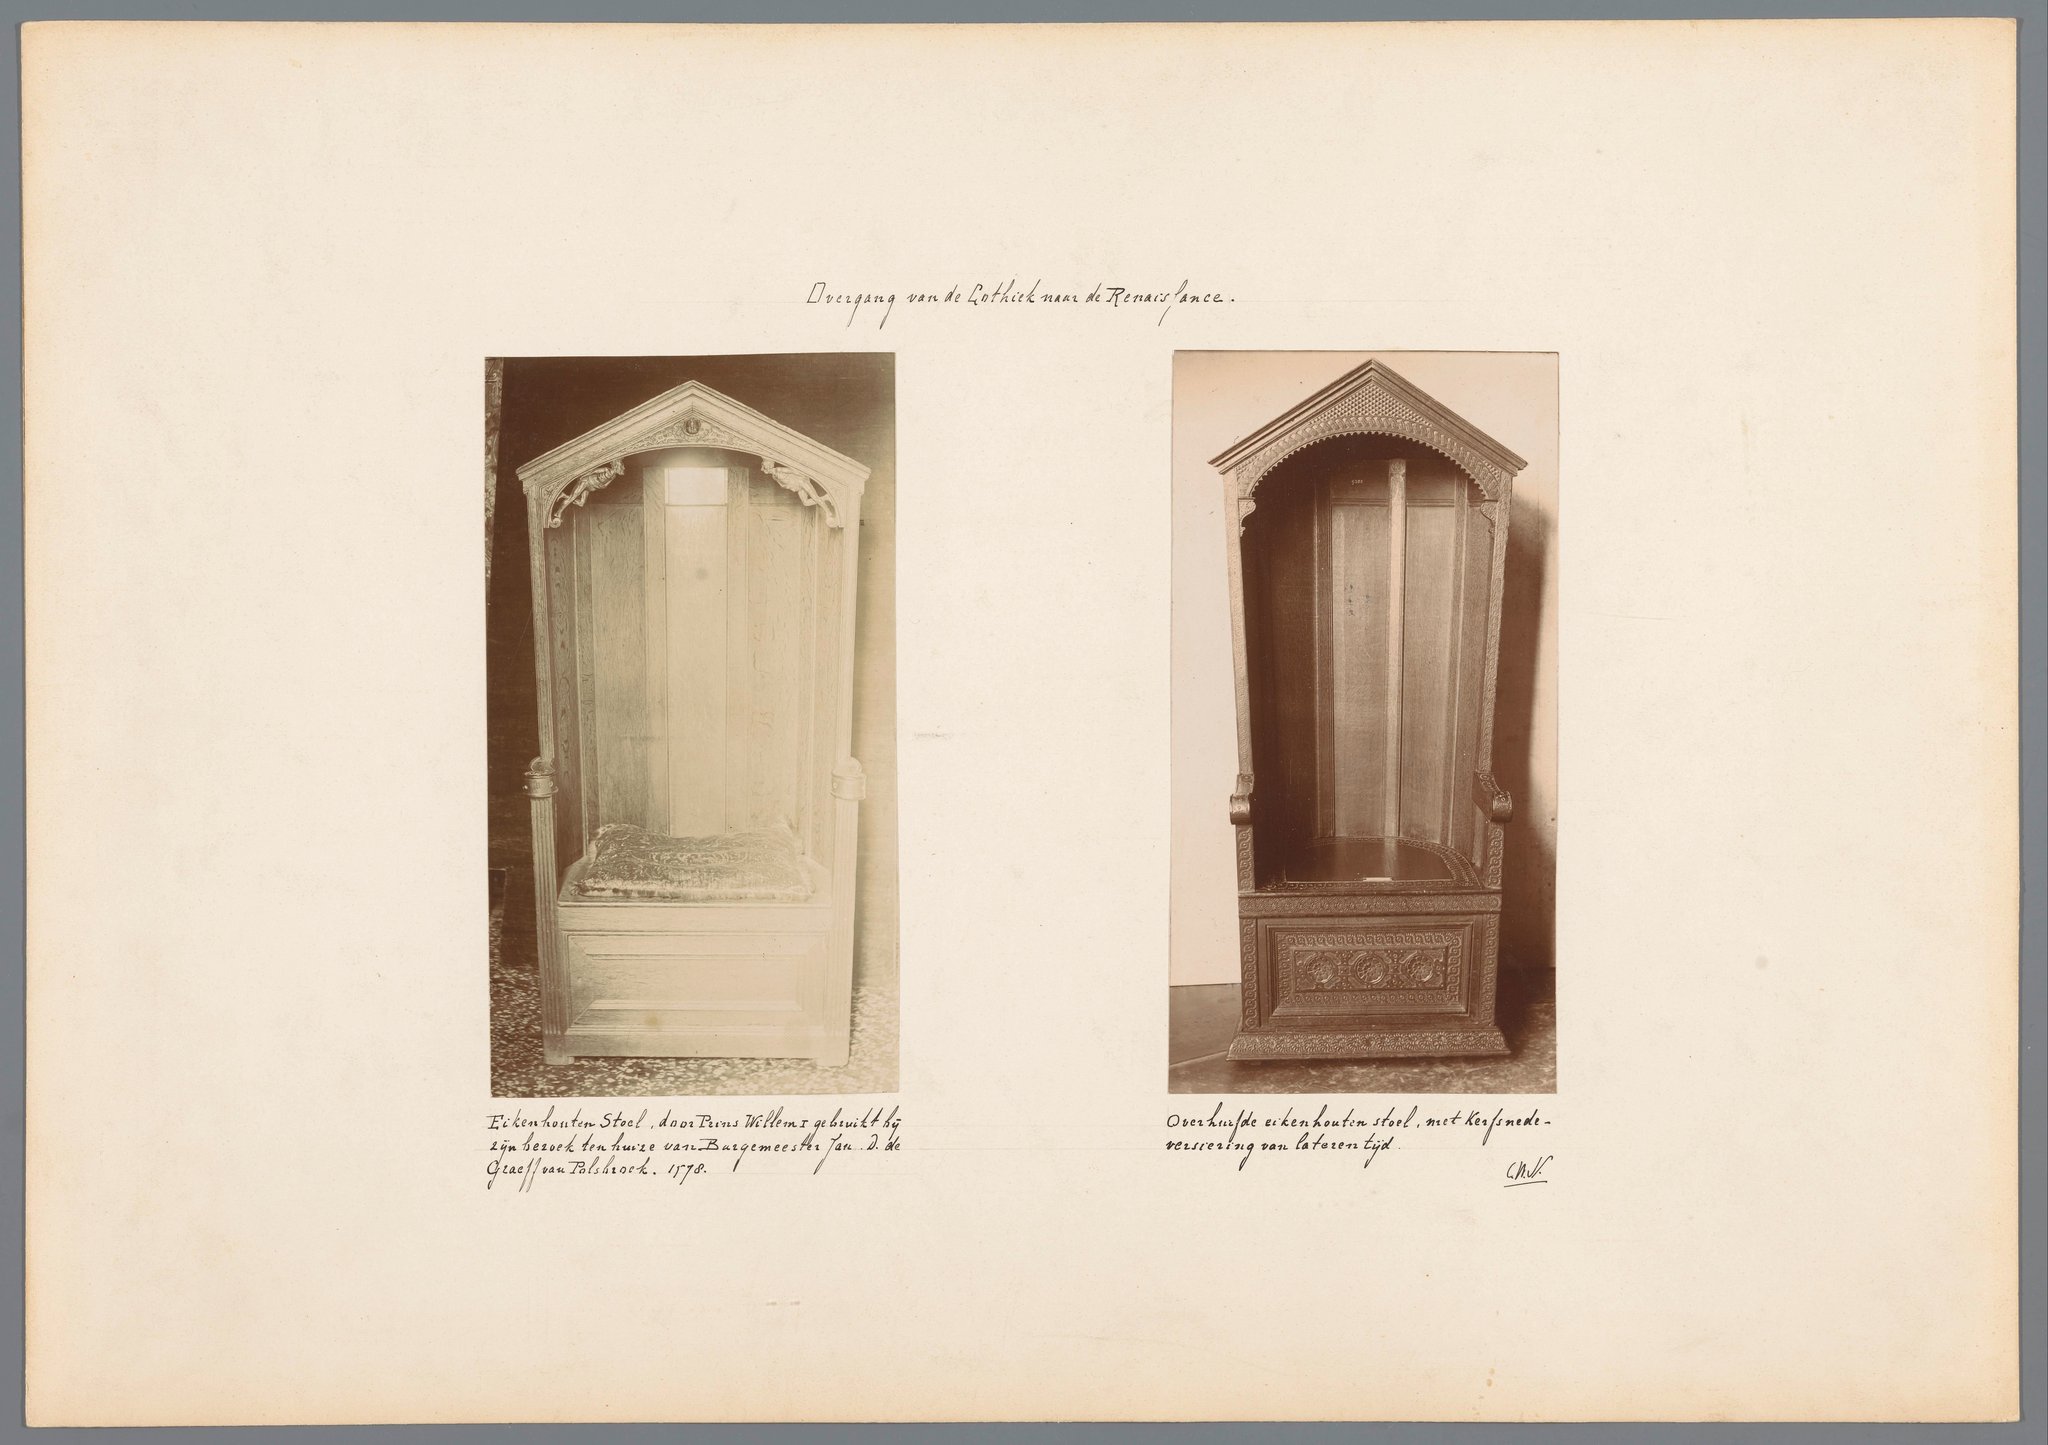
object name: photograph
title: Overzicht van twee eikenhouten stoelen met overkapping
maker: Anonymous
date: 1875-1900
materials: cardboard, photographic support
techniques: daylight paper print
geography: netherlands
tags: chair, sculpture (+ relief ~ sculpture), netherlands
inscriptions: collector's mark: ‘KUNSTNIJVERHEIDSCHOOL QUELLINUS AMSTERDAM FRANS HALSSTRAAT 14.’, name: ‘CWN.’, inscription: ‘Overgang van de Gothiek naar de Renaissance . Eikenhouten Stoel (...) met kerfsnedeversiering van lateren tijd.’, collector's mark: ‘INSTITUUT VOOR KUNST- NIJVERHEIDSONDERWIJS GABRIËL METSUSTRAAT No. 16. AMSTERDAM’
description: Links een eikenhouten stoel met kussen, rechts een eikenhouten stoel met reliëfs.